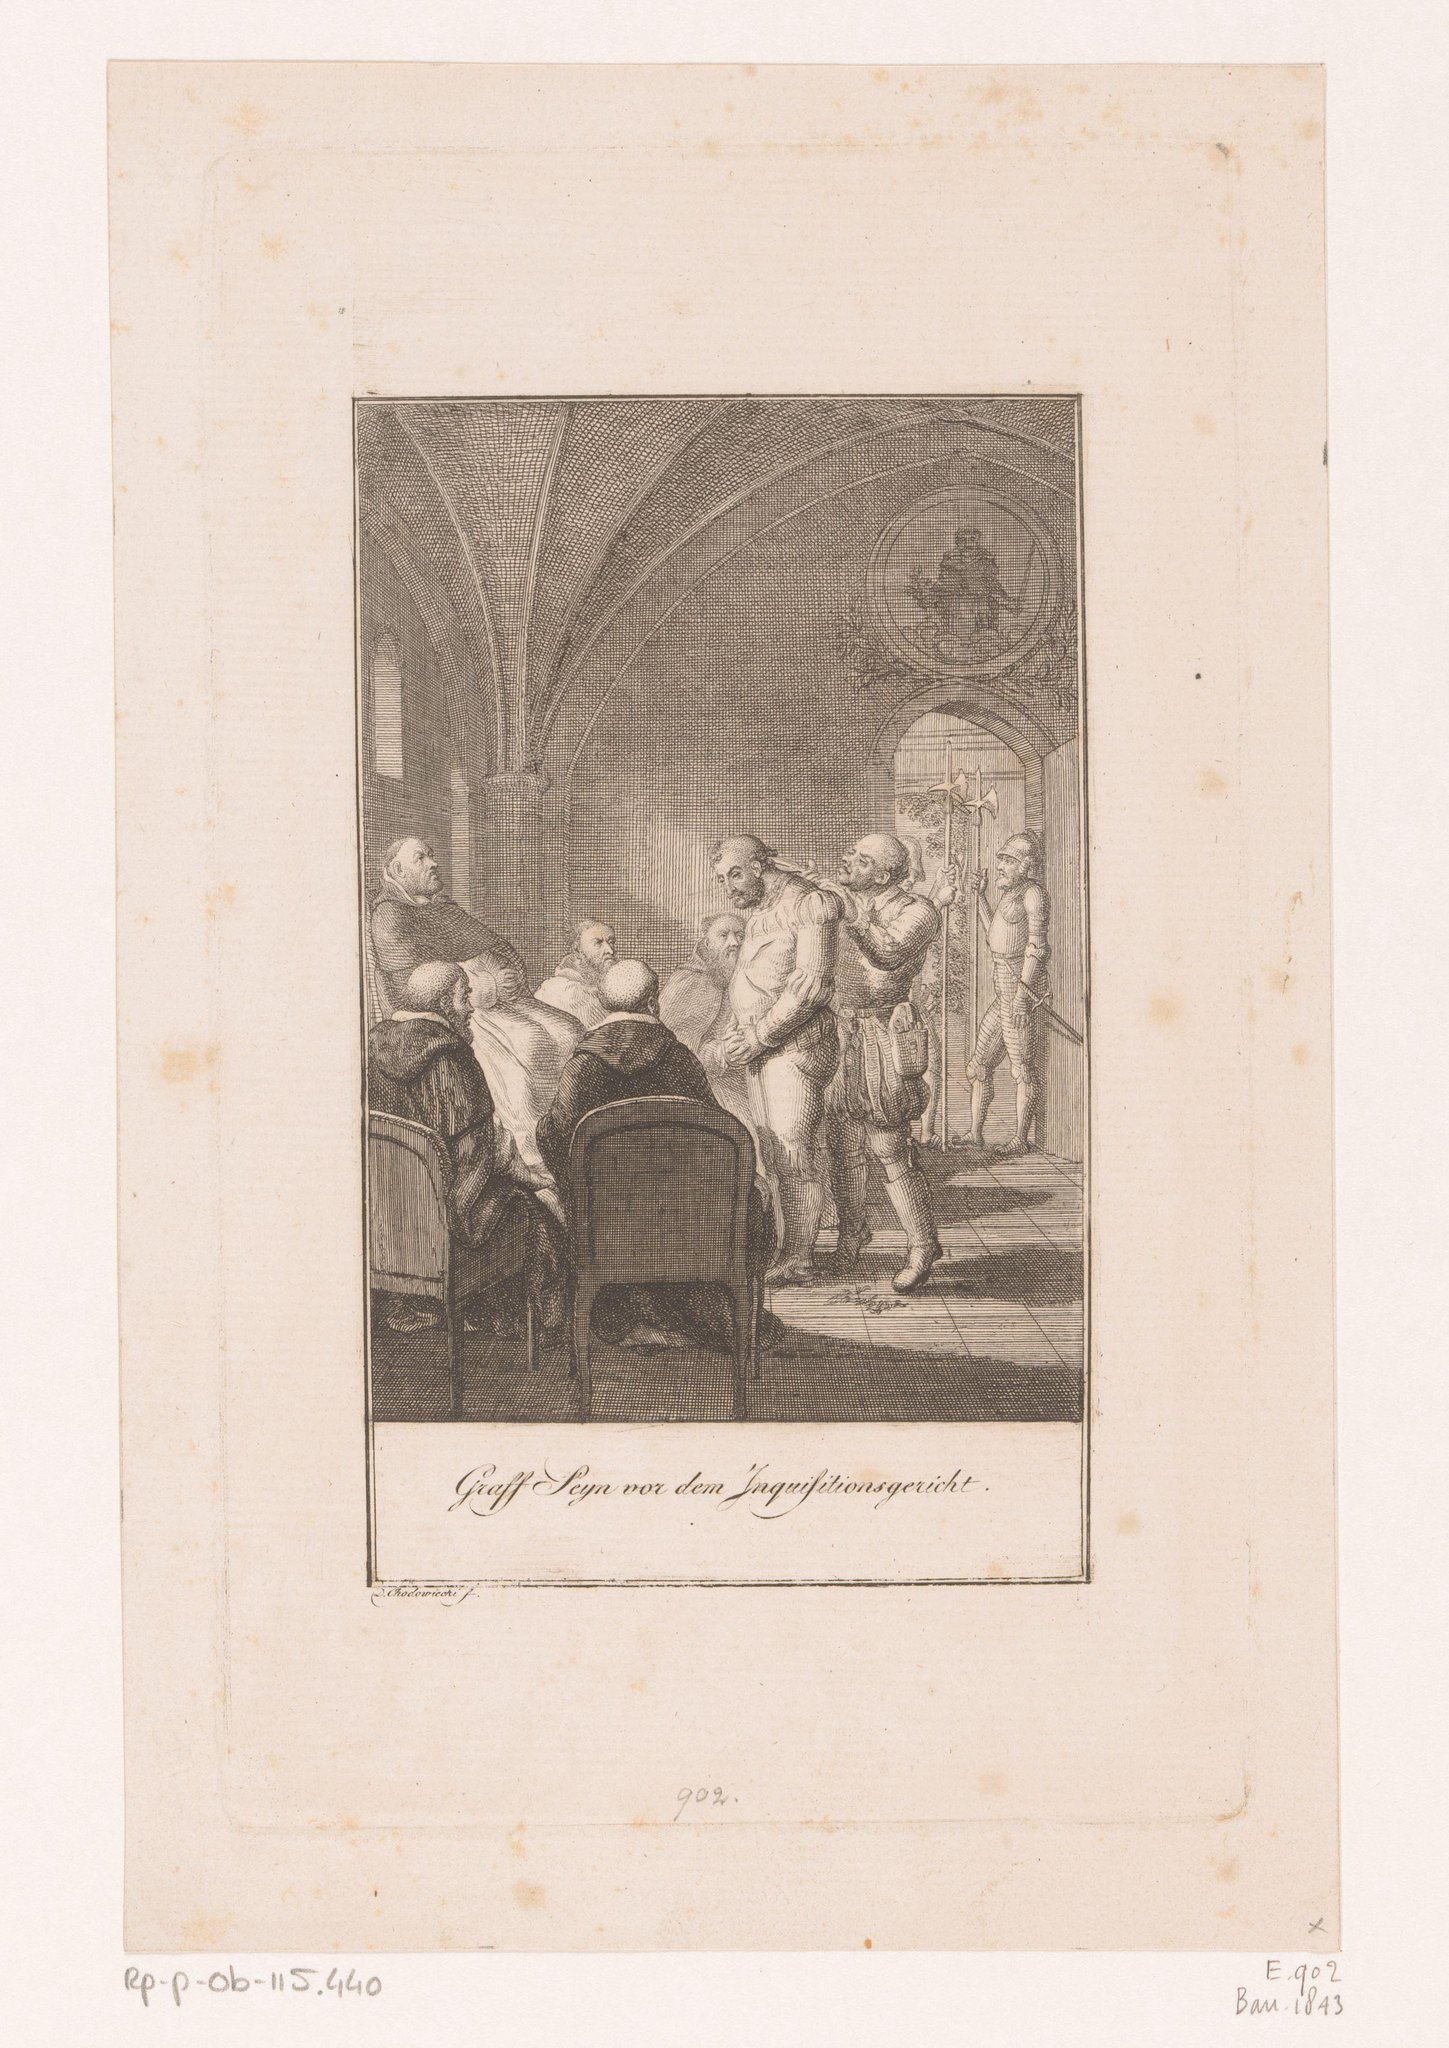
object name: print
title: Graaf van Sayn voor de inquisitie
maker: daniel nikolaus chodowiecki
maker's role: draughtsman, print maker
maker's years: 1726-1801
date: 1798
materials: paper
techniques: etching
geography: berlin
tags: history, inquisition, shaving, being shaved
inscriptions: collector's mark: Lugt 2228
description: Prent gebruikt voor: Deutsche Monatsschrift (...). 3 dln. Leipzig: Sommersche Buchhandlung, 1798.